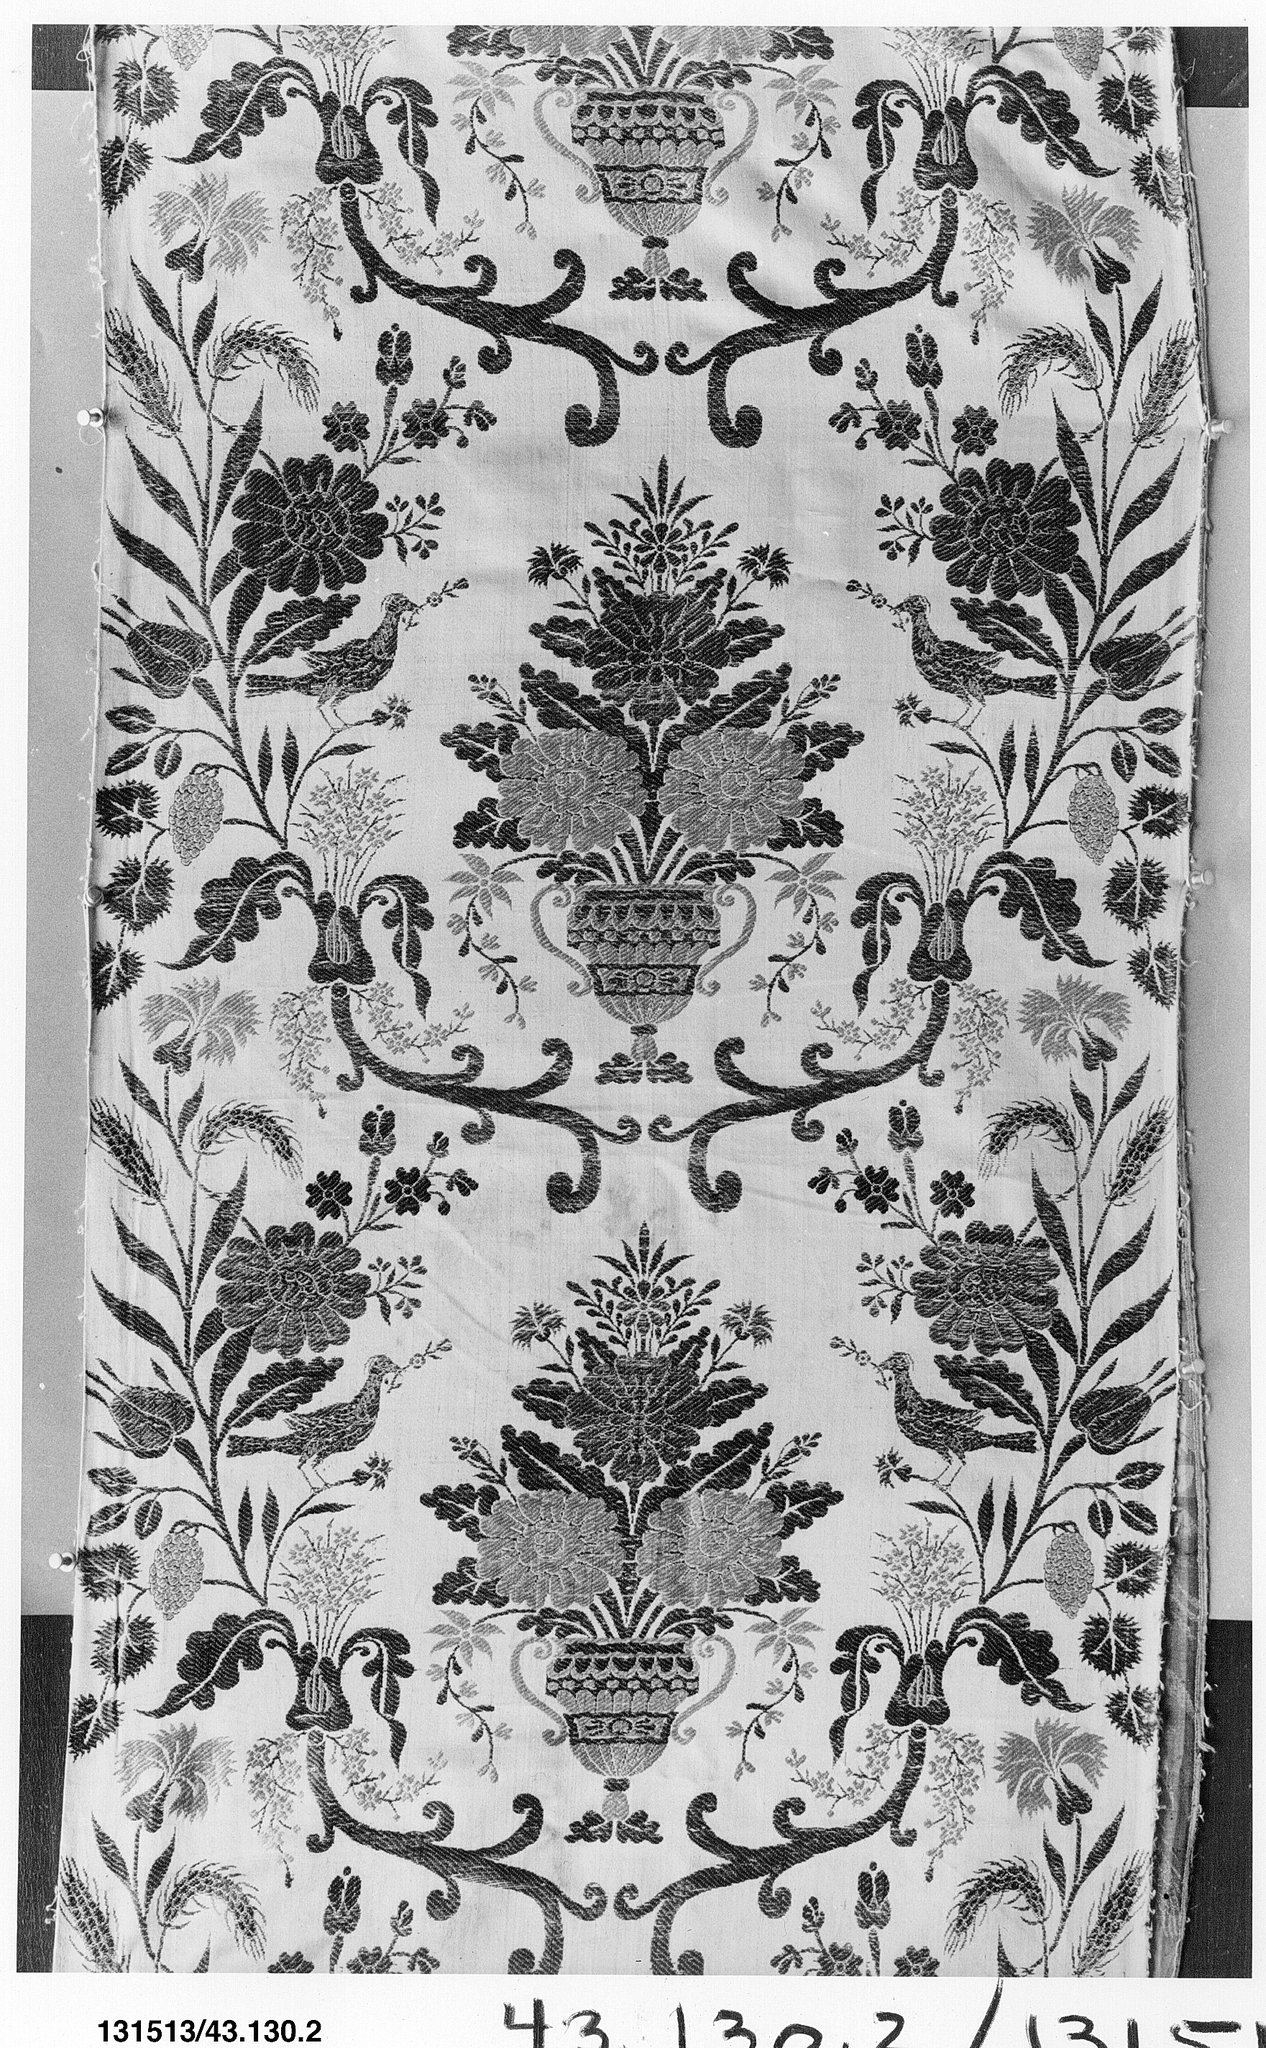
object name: piece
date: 1701-1800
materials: silk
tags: flowers,leaves